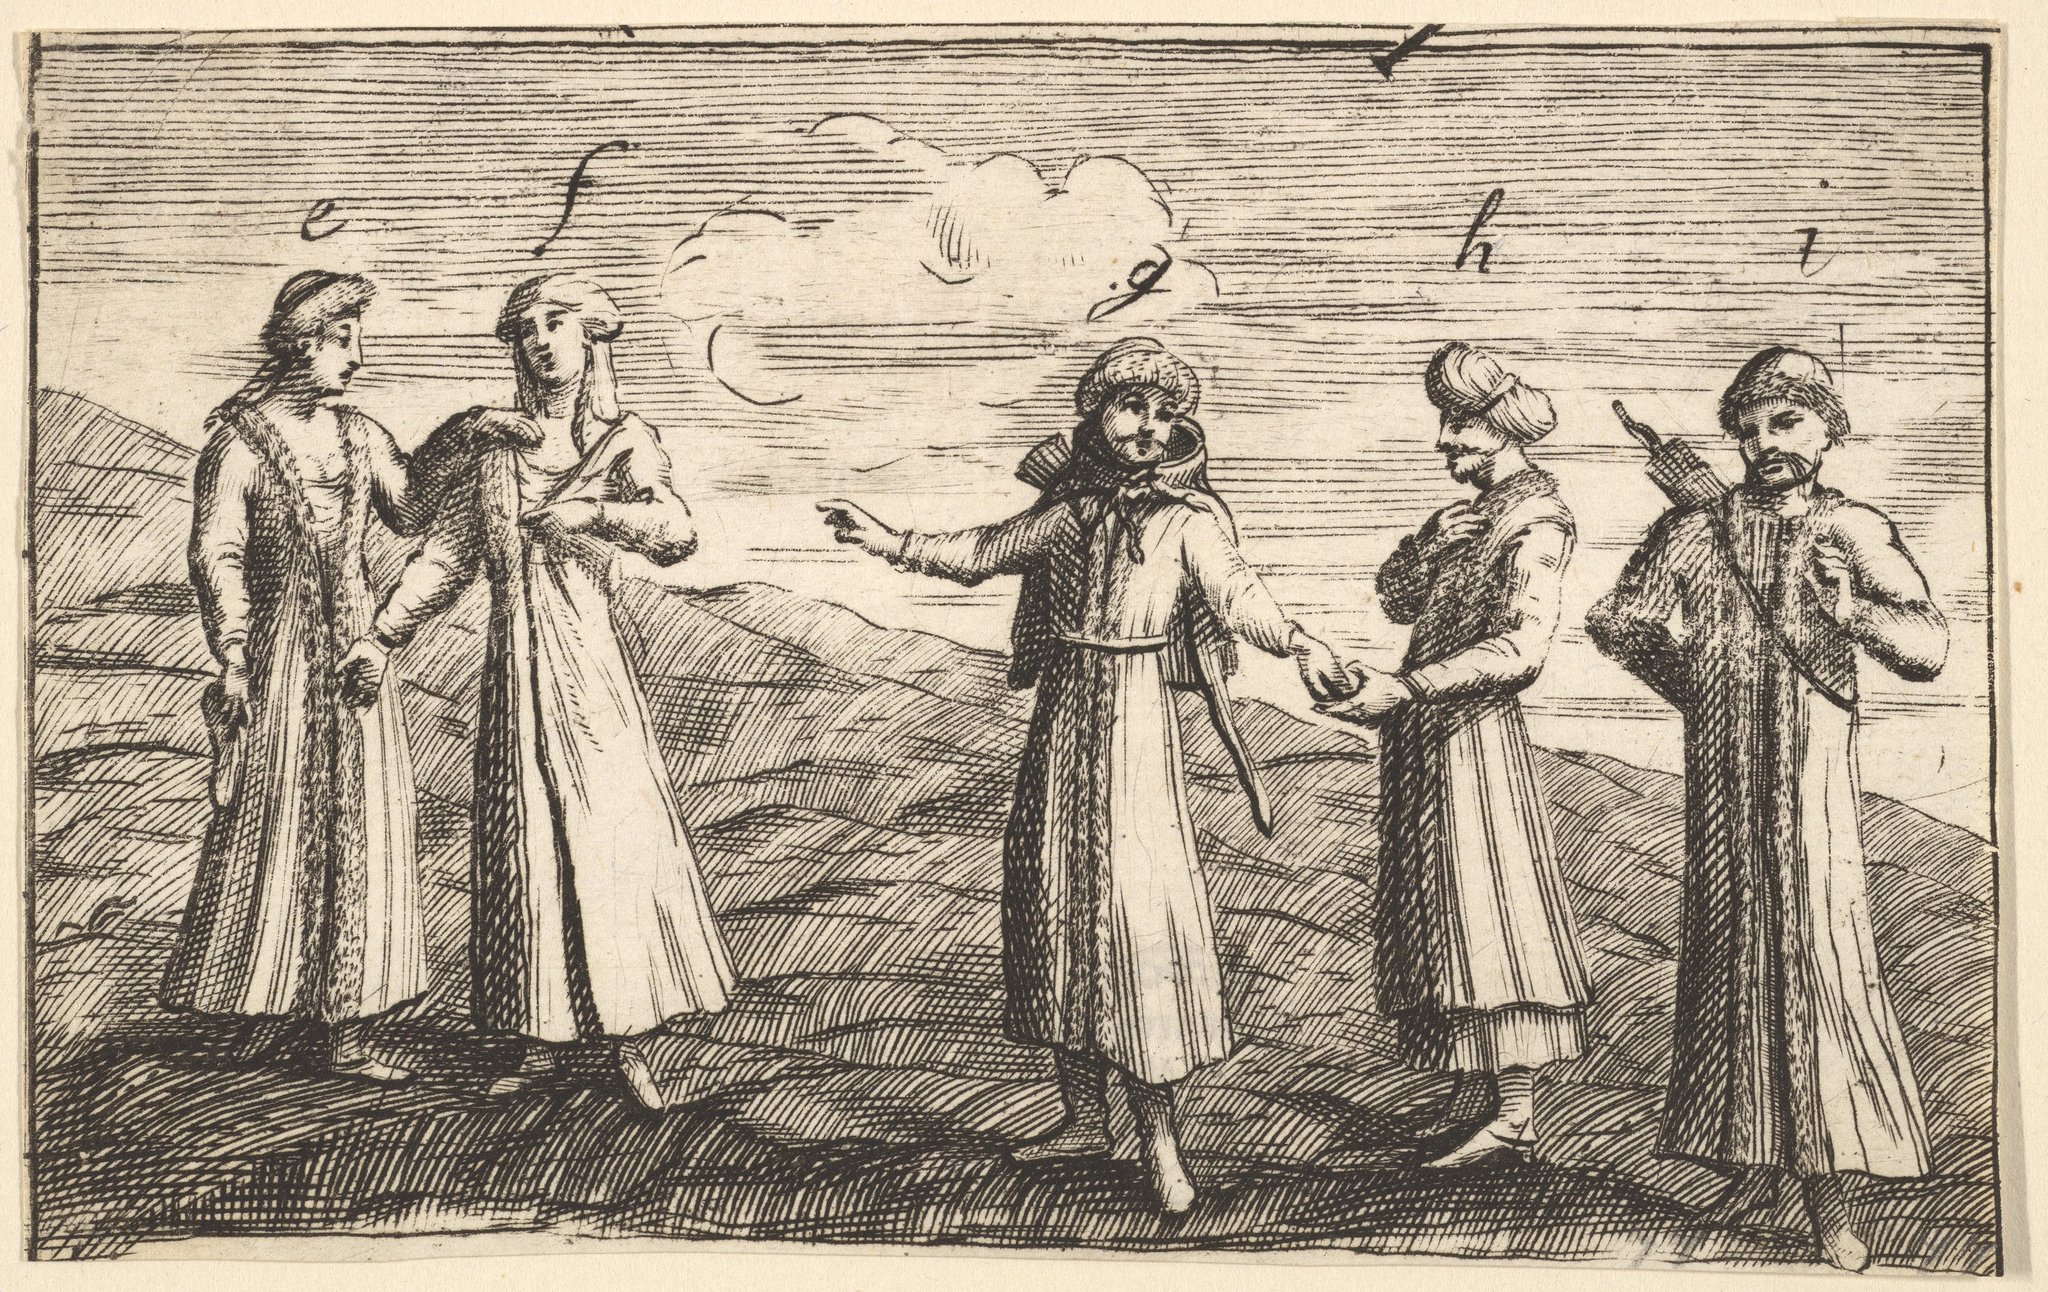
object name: print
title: Five Standing Muscovites (Aubry de La Mottraye's "Travels throughout Europe, Asia and into Part of Africa...," London, 1724, pl. 313)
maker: william hogarth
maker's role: artist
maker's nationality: british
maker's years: 1697-1764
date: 1723-1724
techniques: engraving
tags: men